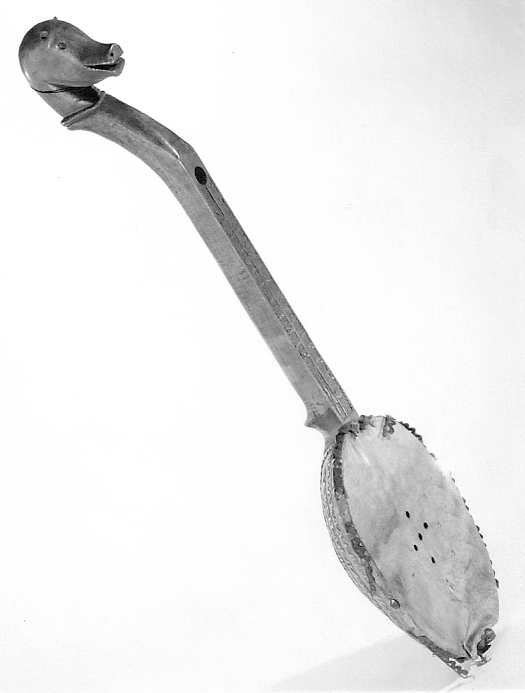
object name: gusle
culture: eastern european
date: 1825-1889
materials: skin, wood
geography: former yugoslavia